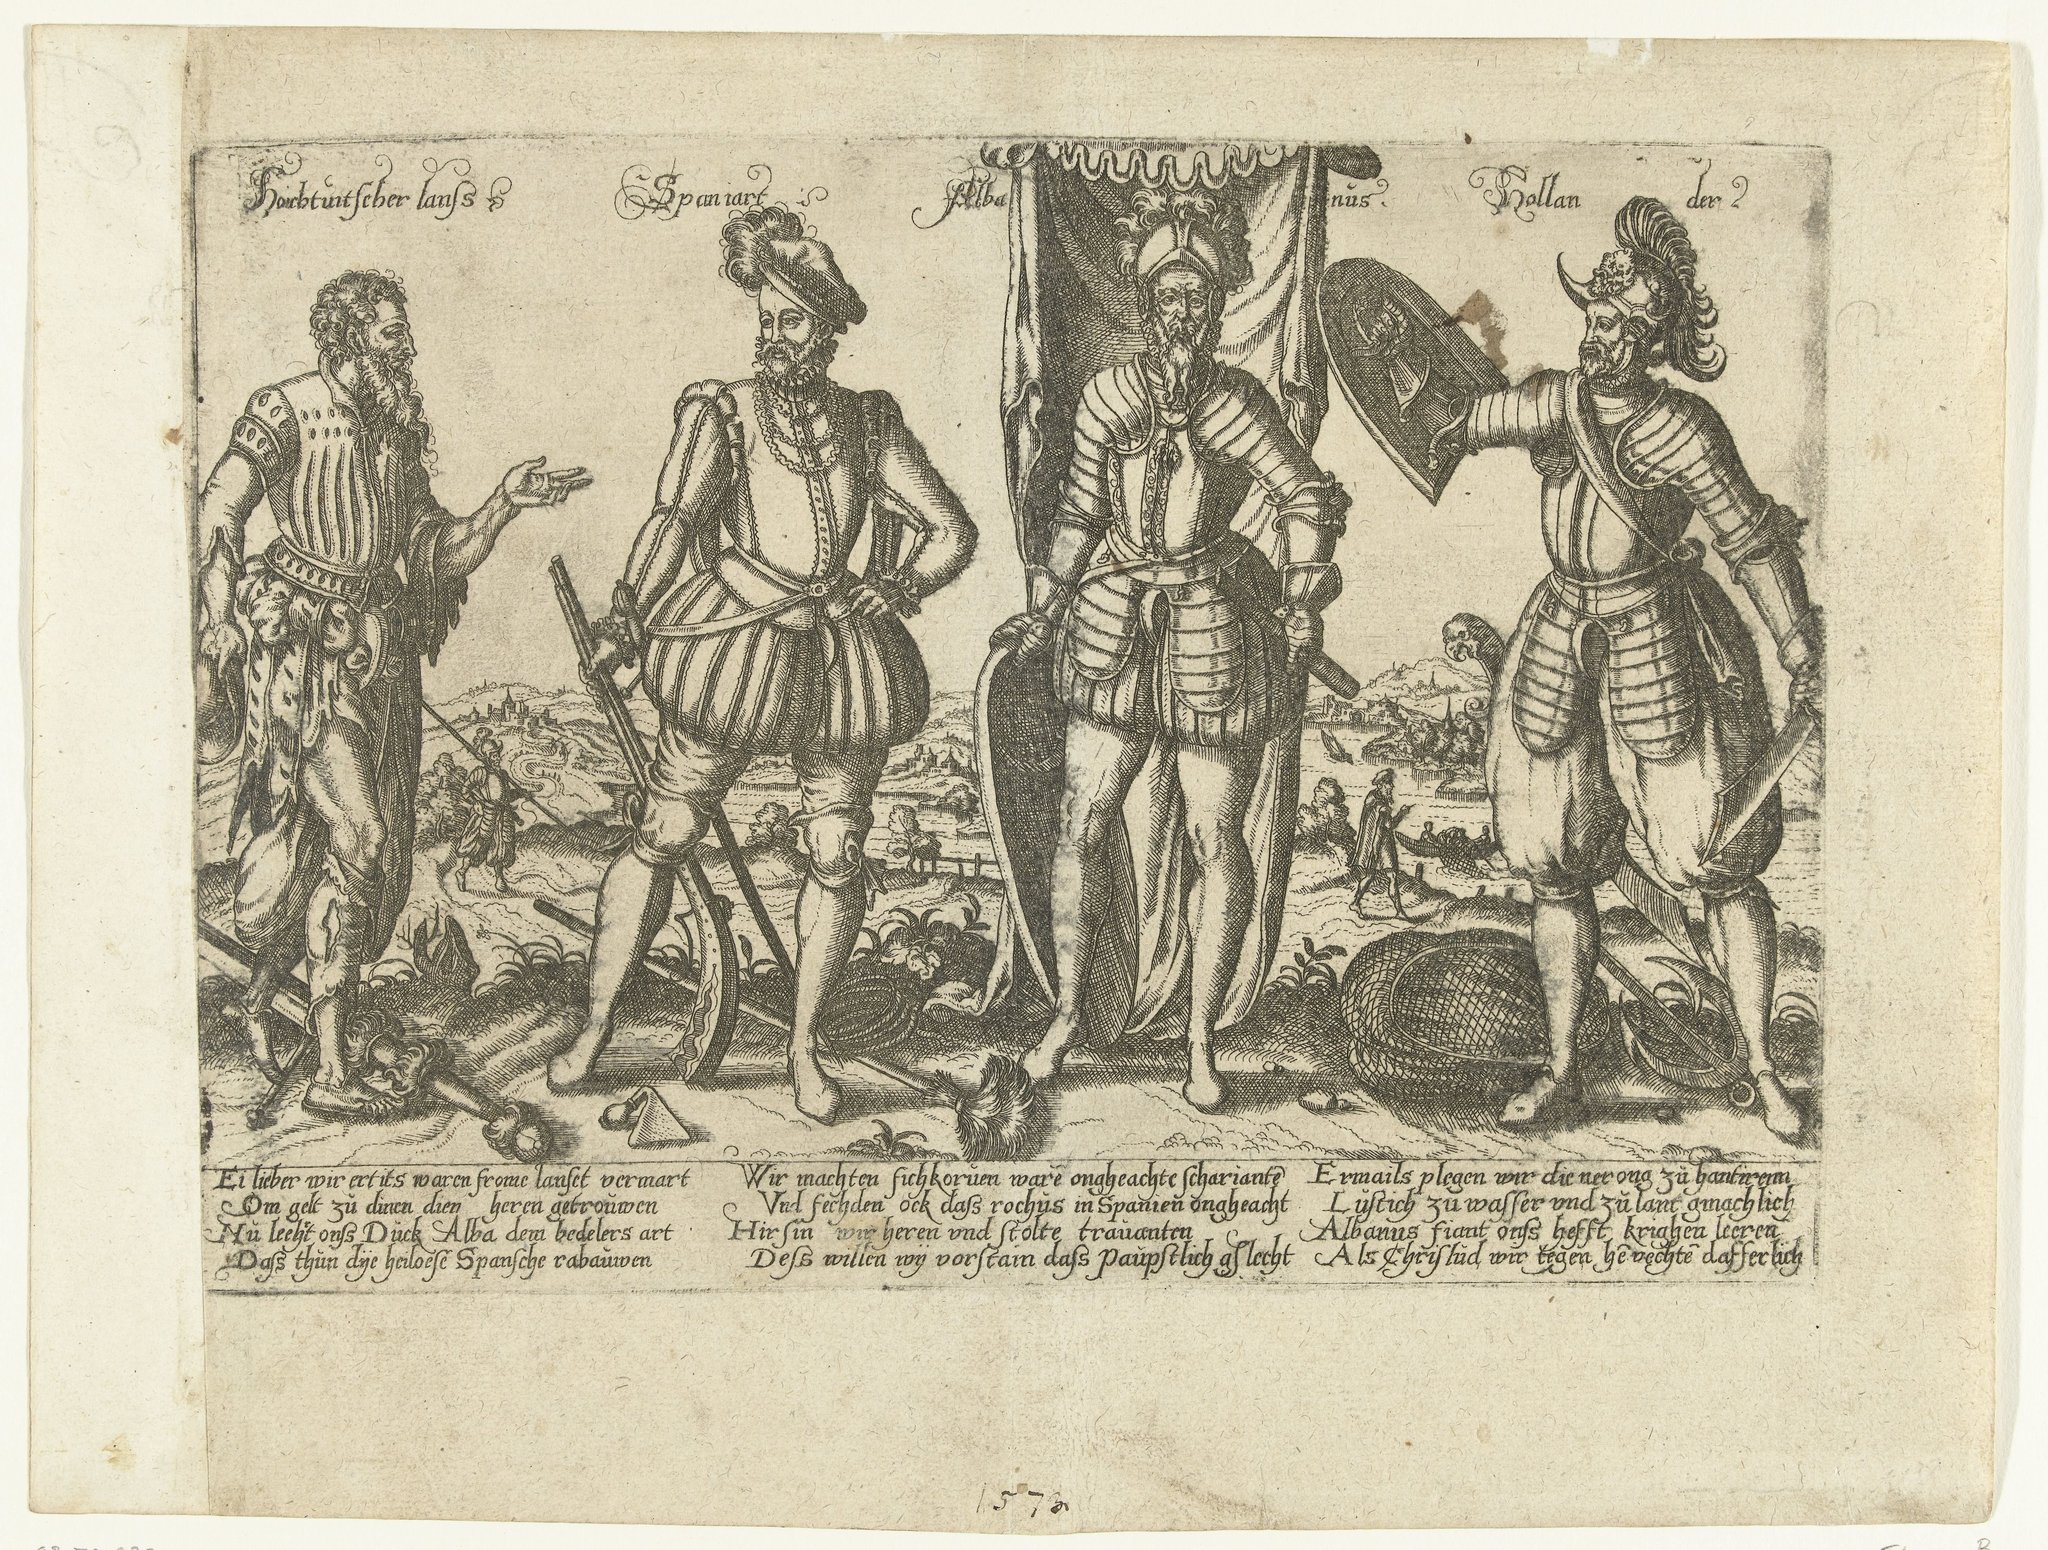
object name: propagandaprent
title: De klacht van de Duitser en de Hollander, ca. 1567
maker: Anonymous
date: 1567-1568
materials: paper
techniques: etching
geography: germany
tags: fernando álvarez de toledo (3rd duke of alba), the soldier; the soldier's life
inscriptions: annotation: ‘1573’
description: Vier figuren staande naast elkaar: Duister, Spanjaard, de hertog van Alva en een Hollander. Een Duitse lansknecht, een Spanjaard en een Hollander geven hun mening over de veranderde situatie in de Nederlanden sinds de komst van Alva. Op de grond attributen van hun professie. Met onderschrift van 3 verzen van 4 regels in het Duits.